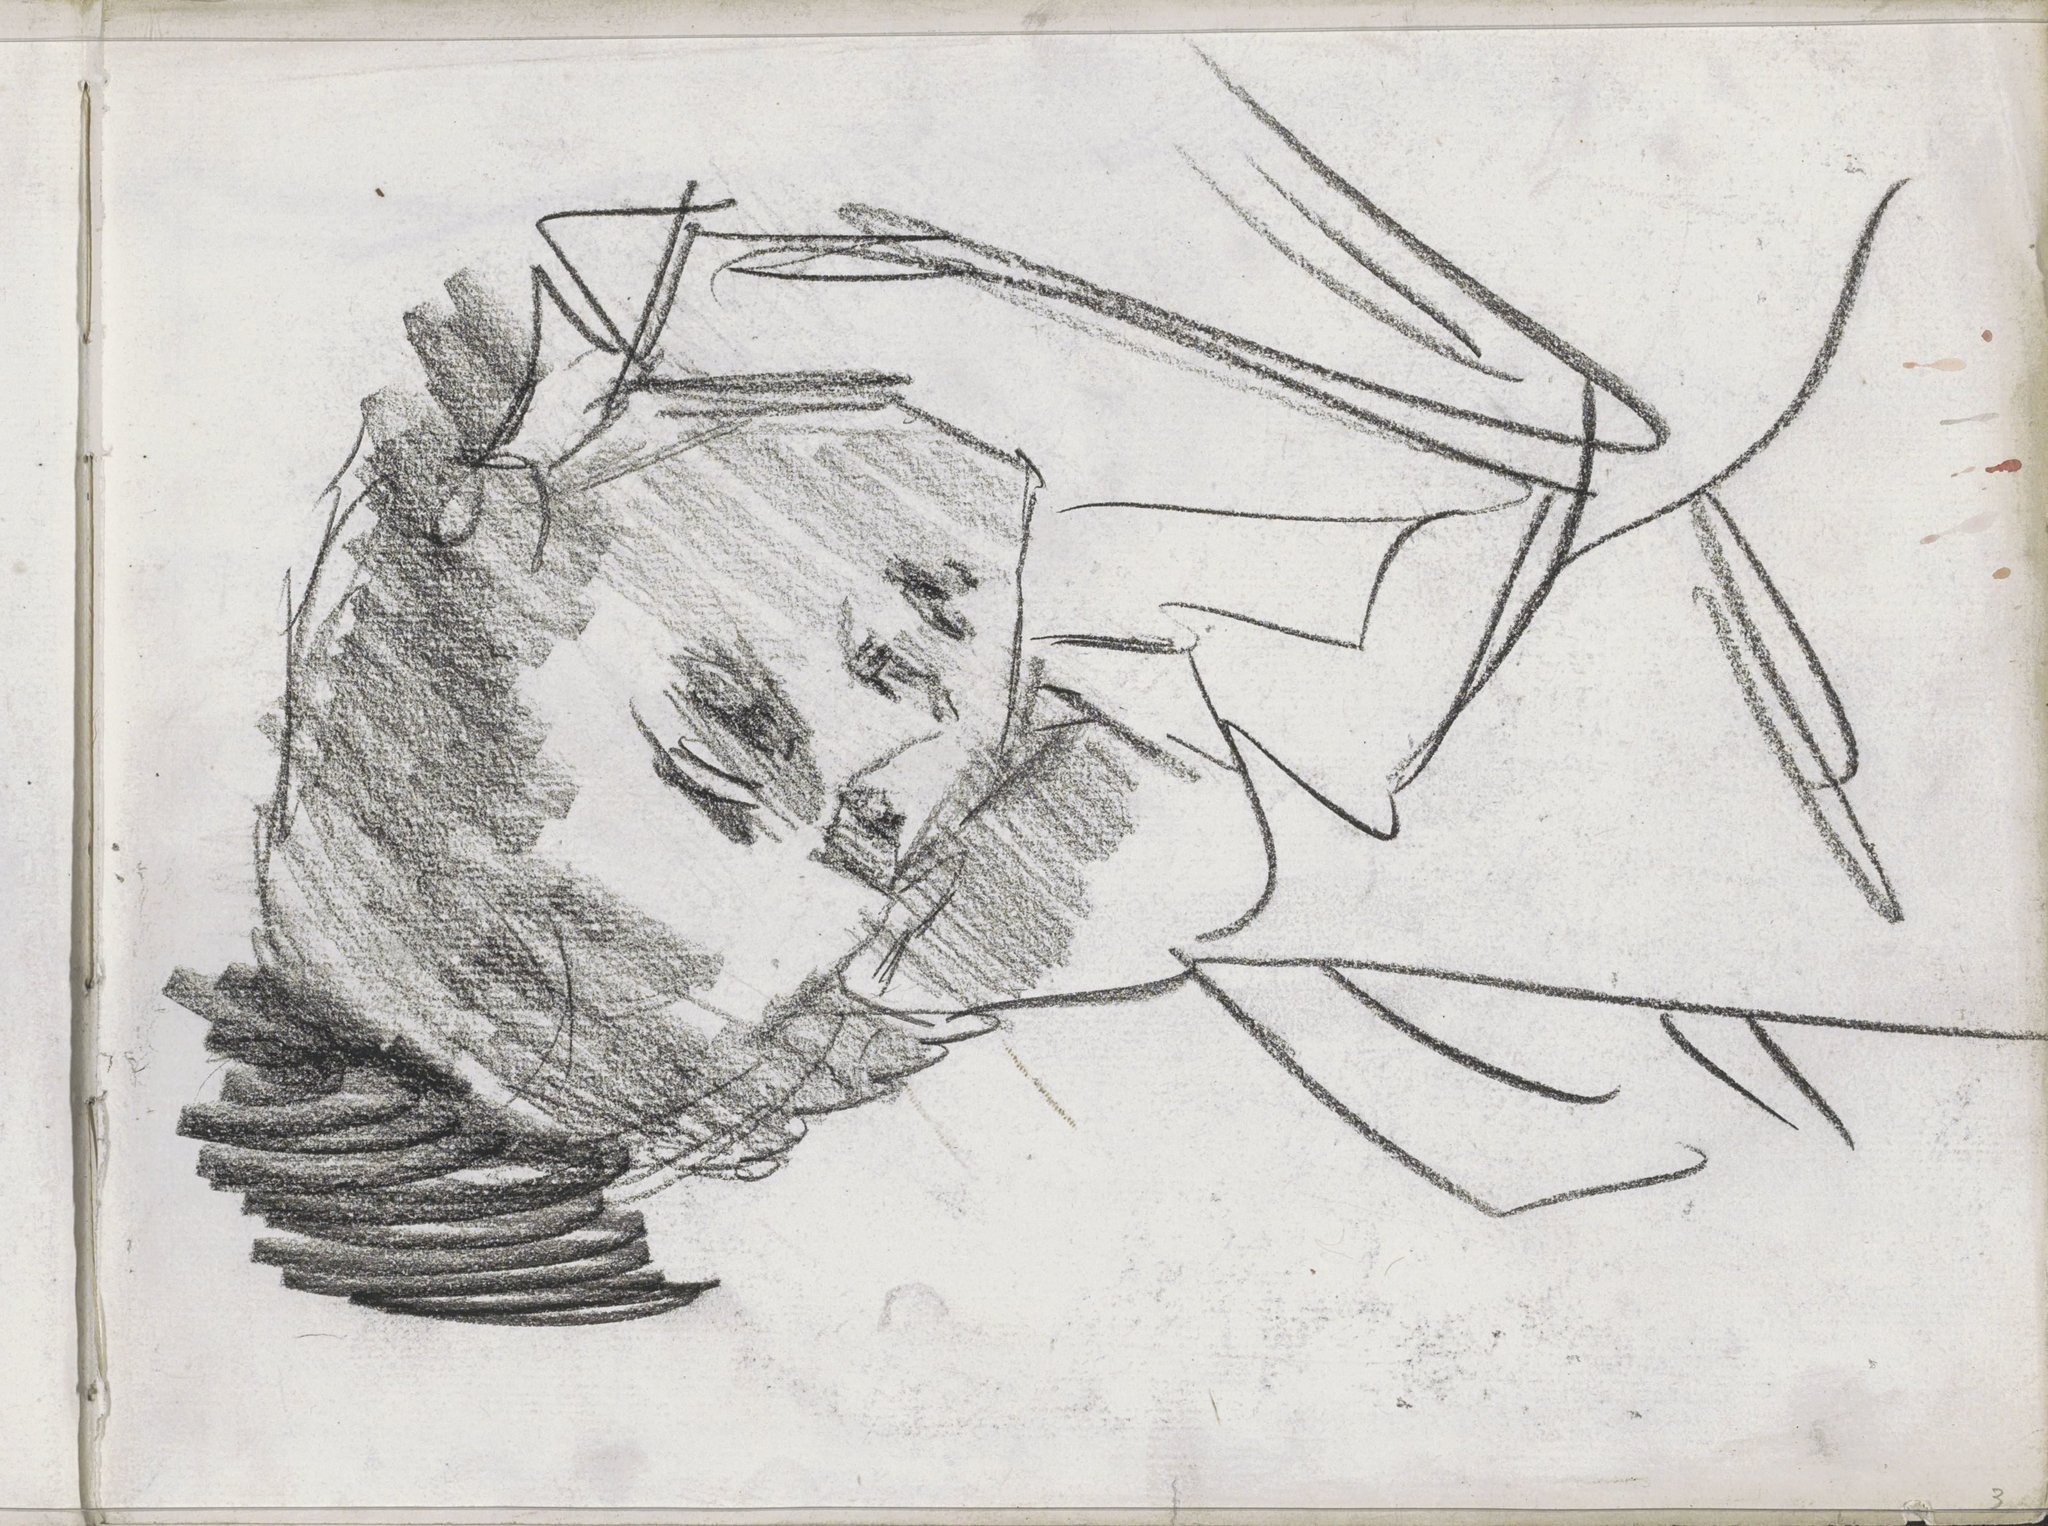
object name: sketchbook leaf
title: Figuur met gebogen hoofd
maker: isaac israels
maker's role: draughtsman, painter, print maker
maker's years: 1865-1934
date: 1875-1934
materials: chalk, paper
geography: the hague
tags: head bent forward; bowing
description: Blad 3 recto uit schetsboek XIV met 17 bladen.